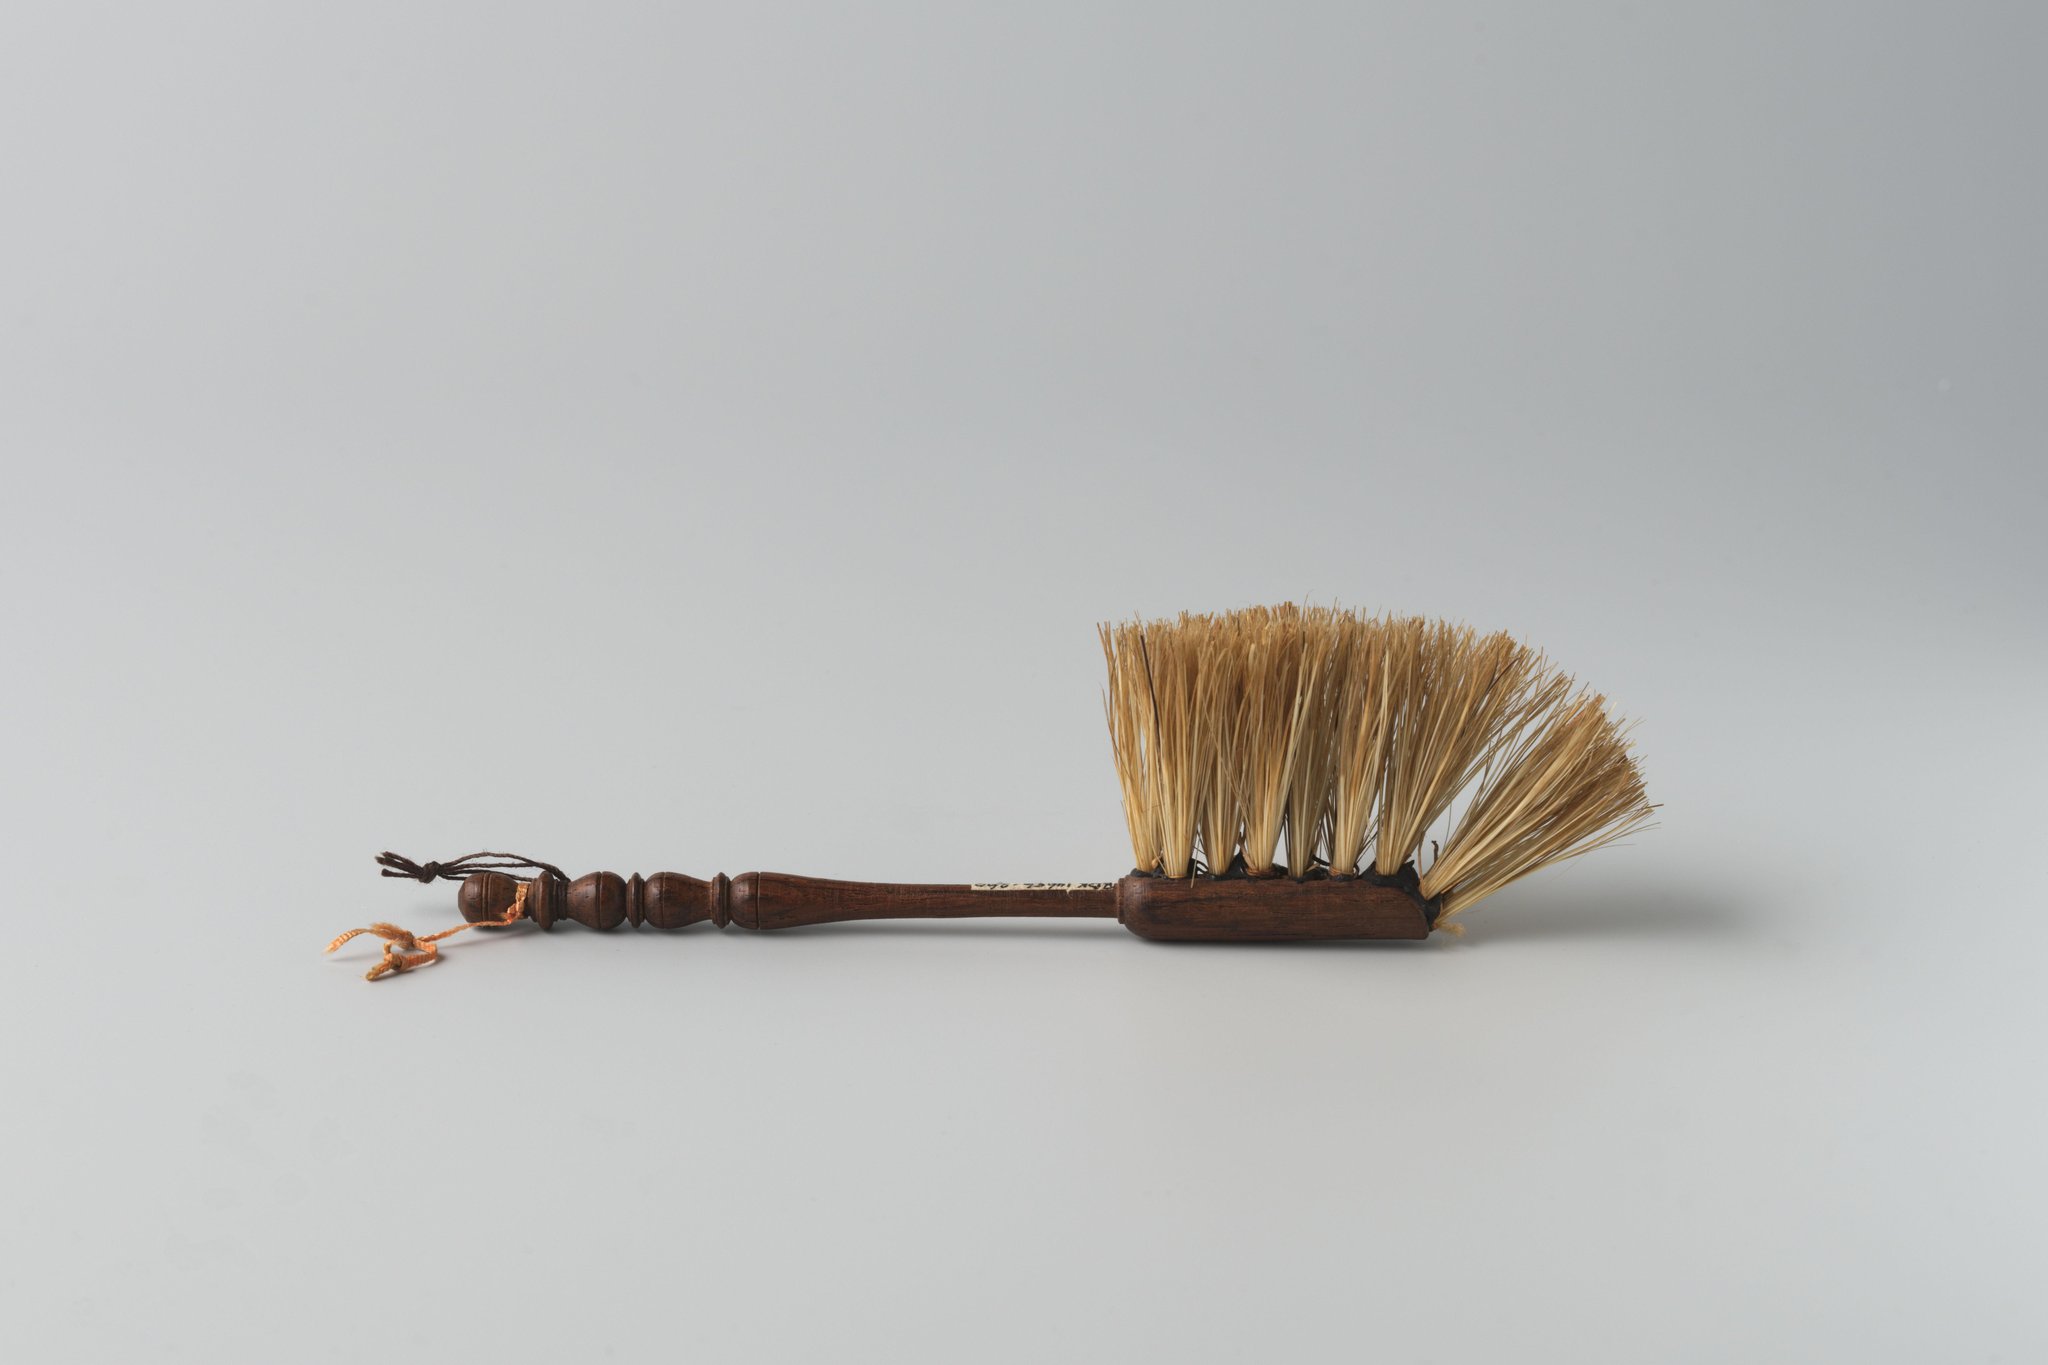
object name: whisk broom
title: Stoffer van palissanderhout en varkenshaar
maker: Anonymous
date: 1676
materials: wood, silk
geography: amsterdam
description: Stoffer van palissanderhout en varkenshaar. De stoffer heeft een ronde rug, aan onderzijde en schuin oplopende voorkant ingezet met haar. De lange gedraaide steel met profielen en balusters. Om de knop is een roze zijden lint geknoopt.